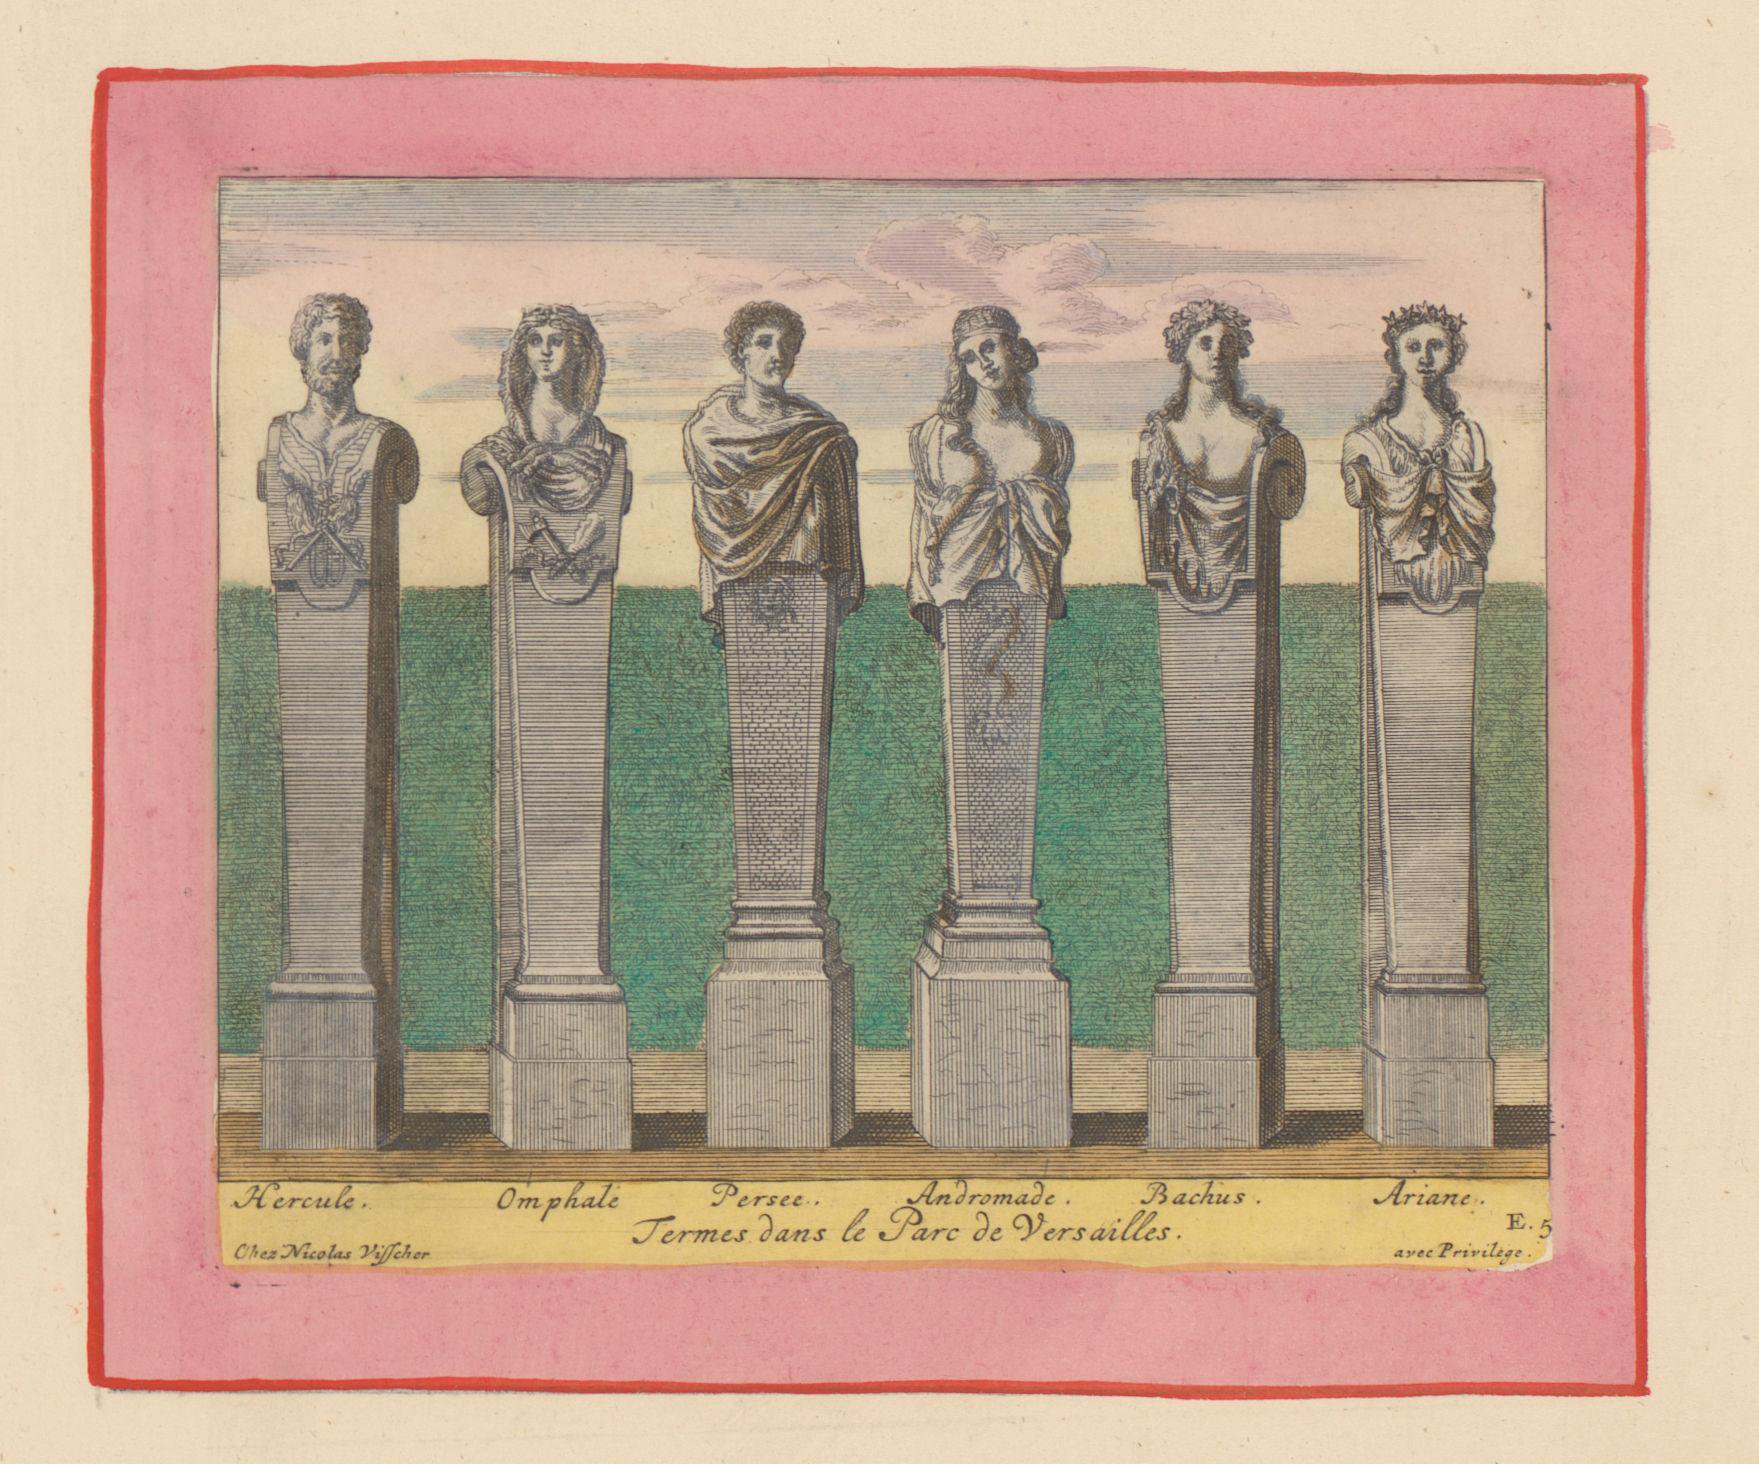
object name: album leaf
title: Termes dans le Parc de Versailles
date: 1686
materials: paper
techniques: etching, hand coloring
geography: the hague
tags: perseus and andromeda, (story of) hercules (heracles), herms (garden ornaments), (story of) bacchus (dionysus), liber, (story of) ariadne, (story of) perseus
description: Hermen in de tuinen van Versailles. Van links naar rechts: Hercules, Omphale, Perseus, Andromeda, Bacchus en Ariadne. Rechtsonder het serienummer: E5. Prent maakt deel uit van een album.